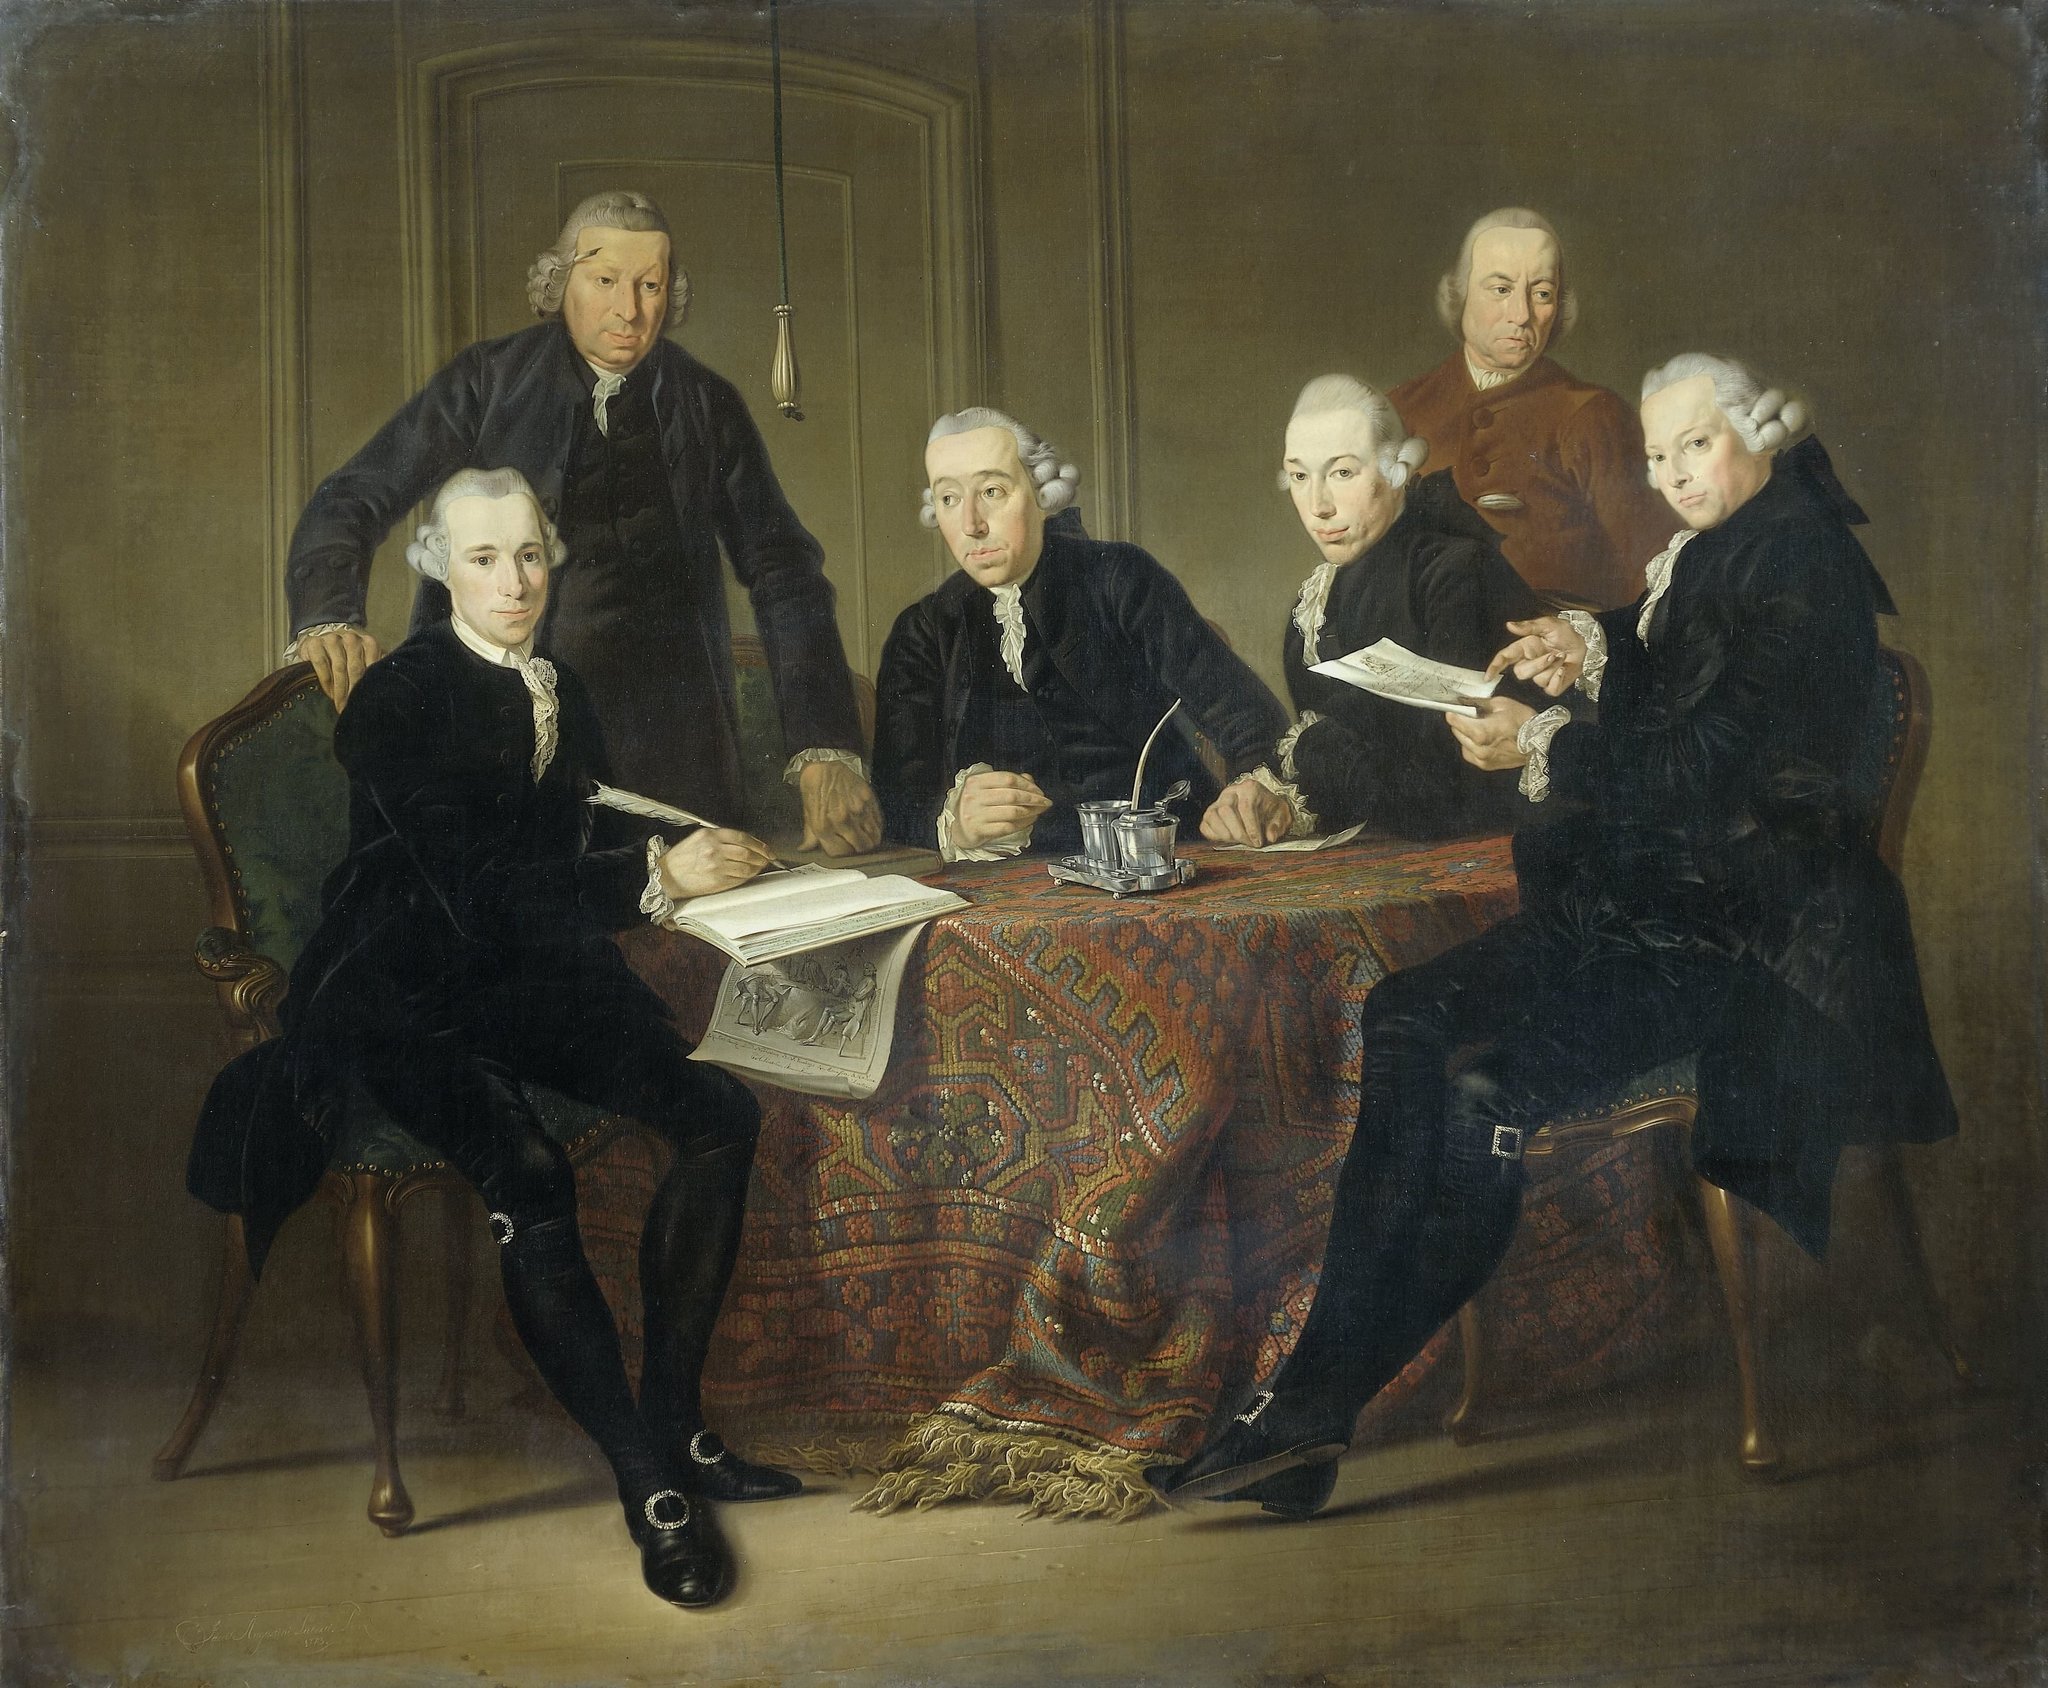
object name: painting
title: The Four Regents, the Secretary and the House Father of the Lepers' House of Amsterdam, 1773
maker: jacobus luberti augustini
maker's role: draughtsman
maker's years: 1748-1822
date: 1773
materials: canvas, oil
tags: board, esp. governors, trustees, etc. (dutch: 'regenten')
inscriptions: signature and date: ‘Jacobs Augustini Luberti Pinx. 1773’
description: De vier regenten van het Leprozenhuis te Amsterdam in het jaar 1773. Groepsportret rond een tafel: R.J. van den Broeke, H. van Veen, J. Veening, M. van Son, de binnenvader H. Linteloo en D. Nolthenius.